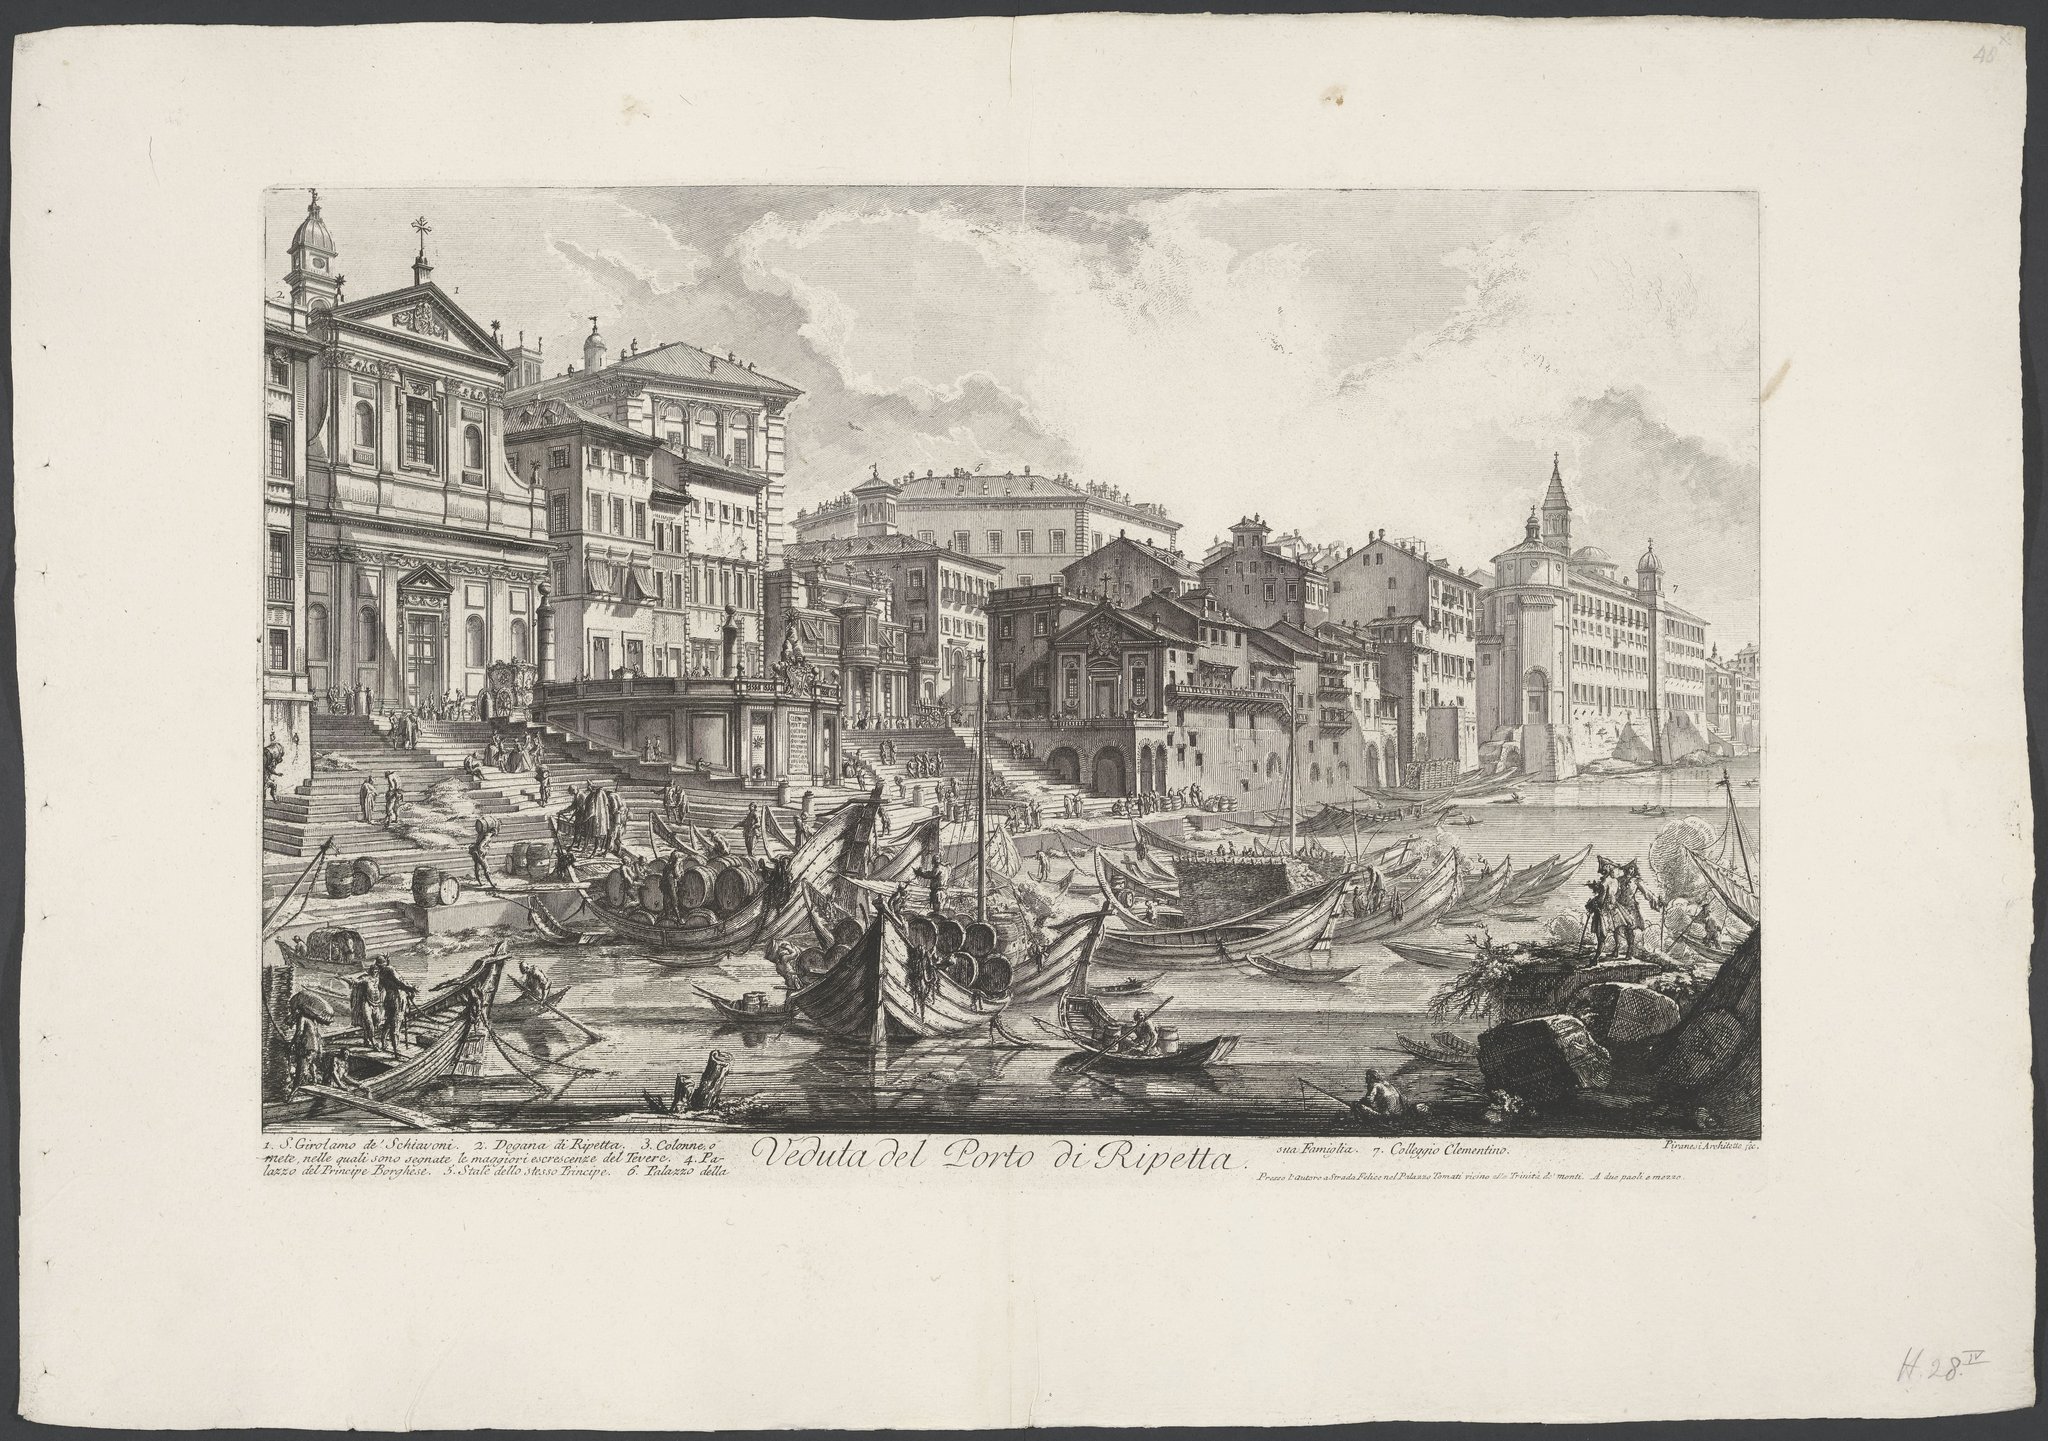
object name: print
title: Vedute di Roma disegnate ed incise da Giambattista Piranesi architetto Ve(nez)iano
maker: giovanni battista piranesi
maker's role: designer, draughtsman, print maker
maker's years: 1720-1778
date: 1748-1778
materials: paper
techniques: etching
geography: rome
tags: harbour, river, rome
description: Deze prent maakt deel uit van de serie 'Vedute di Roma'. Piranesi werkte aan deze 135 platen tellende serie tussen 1748 en zijn dood in 1778. Francesco Piranesi voegde later nog twee prenten toe aan de reeks van zijn vader.